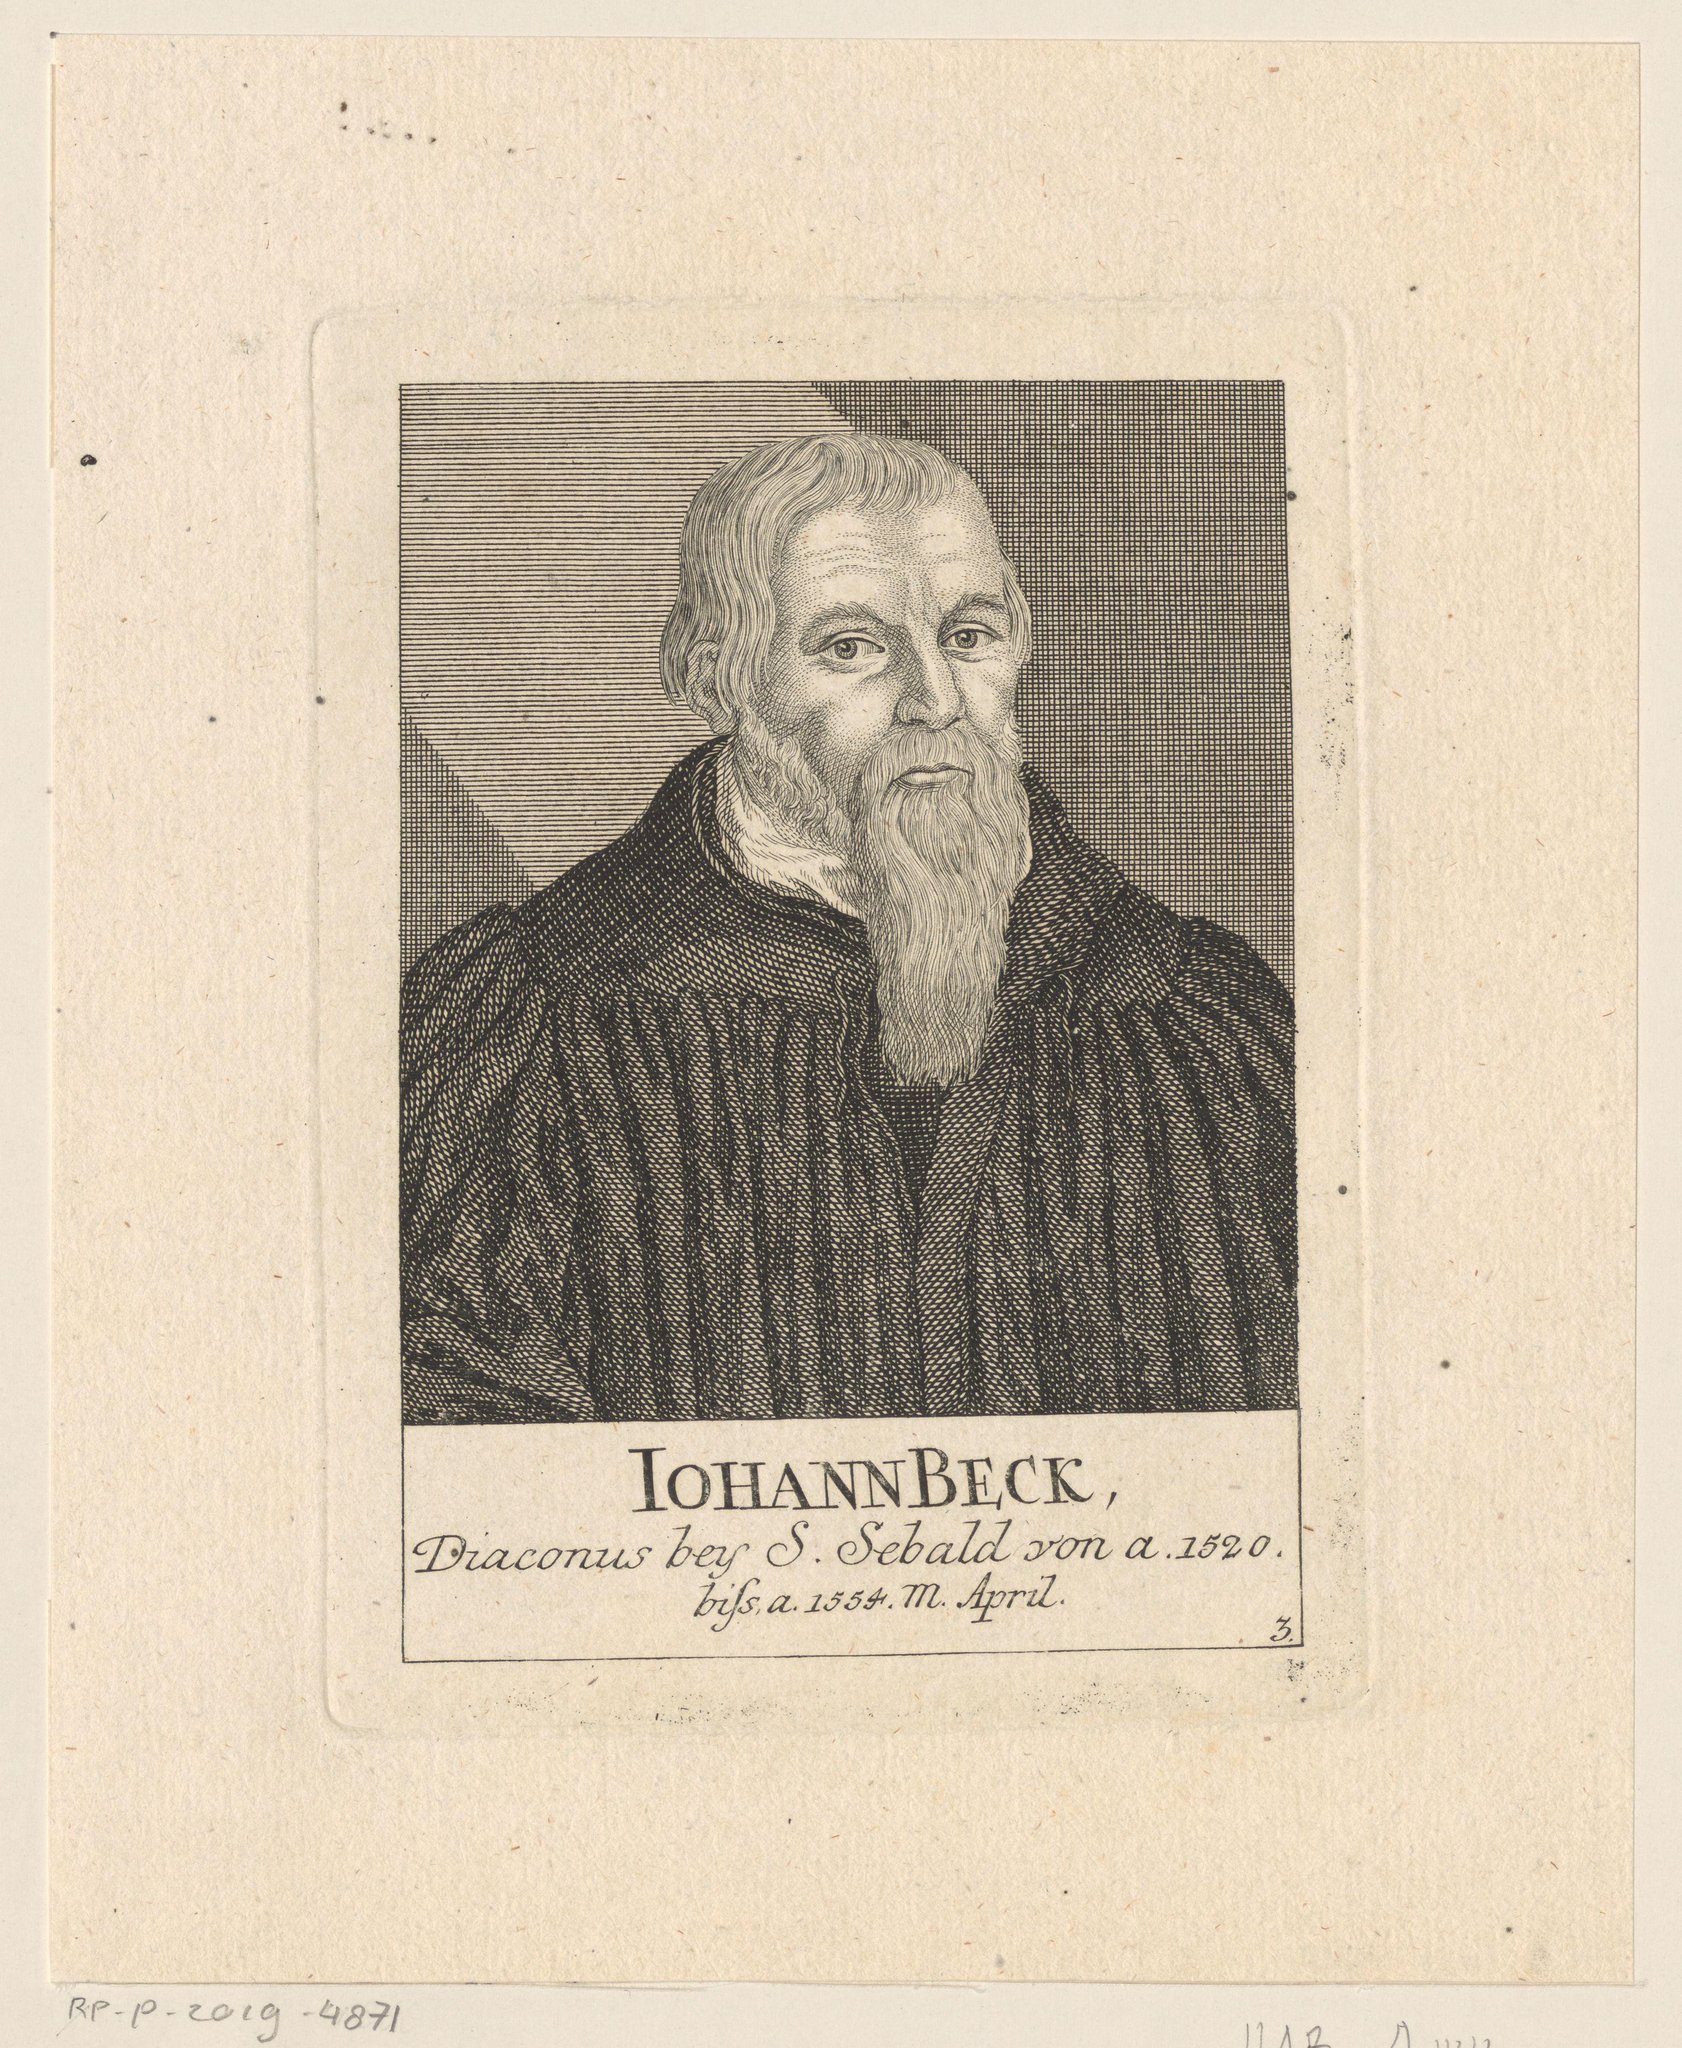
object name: print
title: Portret van Johann Beck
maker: christoph melchior roth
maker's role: print maker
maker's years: 1720-1798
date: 1756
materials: paper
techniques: engraving, etching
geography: nuremberg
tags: theologian, historical persons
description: Prent uit: Würfel, Andreas. Diptycha ecclesiae Sebaldianae (...). Neurenberg: Christoph Melchior Roth, 1756.